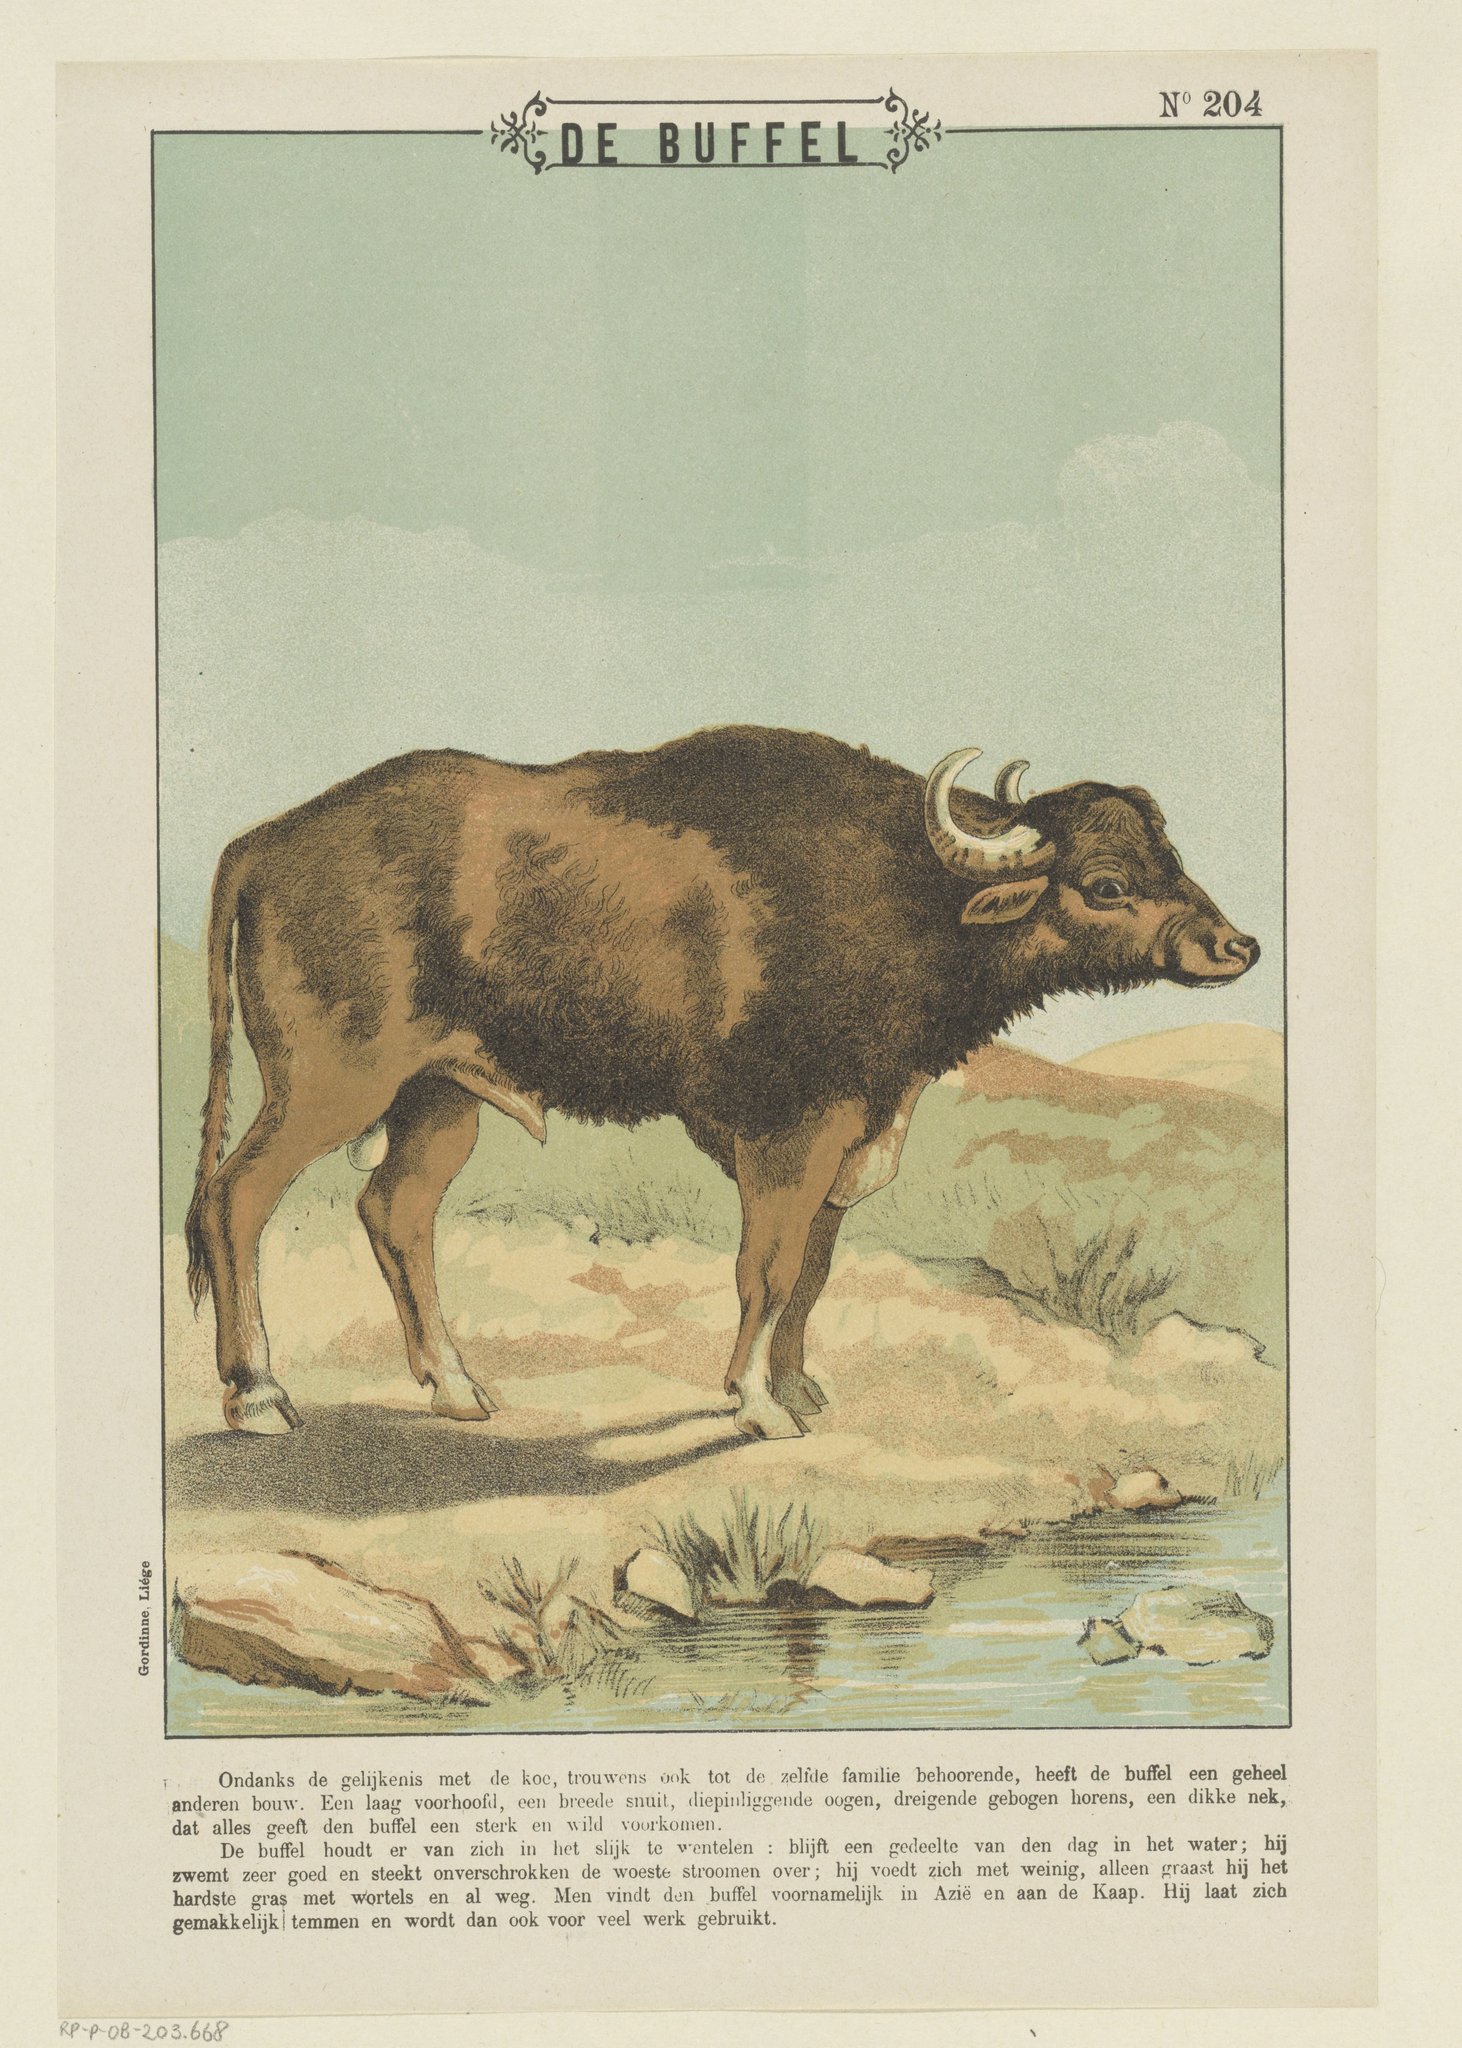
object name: print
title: De buffel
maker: Anonymous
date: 1894-1959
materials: paper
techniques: lithograph, letterpress printing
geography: liège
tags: hoofed animals: buffalo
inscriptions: collector's mark: Lugt 2760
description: Blad met een grote voorstelling van een buffel aan de waterkant. In de ondermarge een onderschrift. Genummerd rechtsboven: No 204.